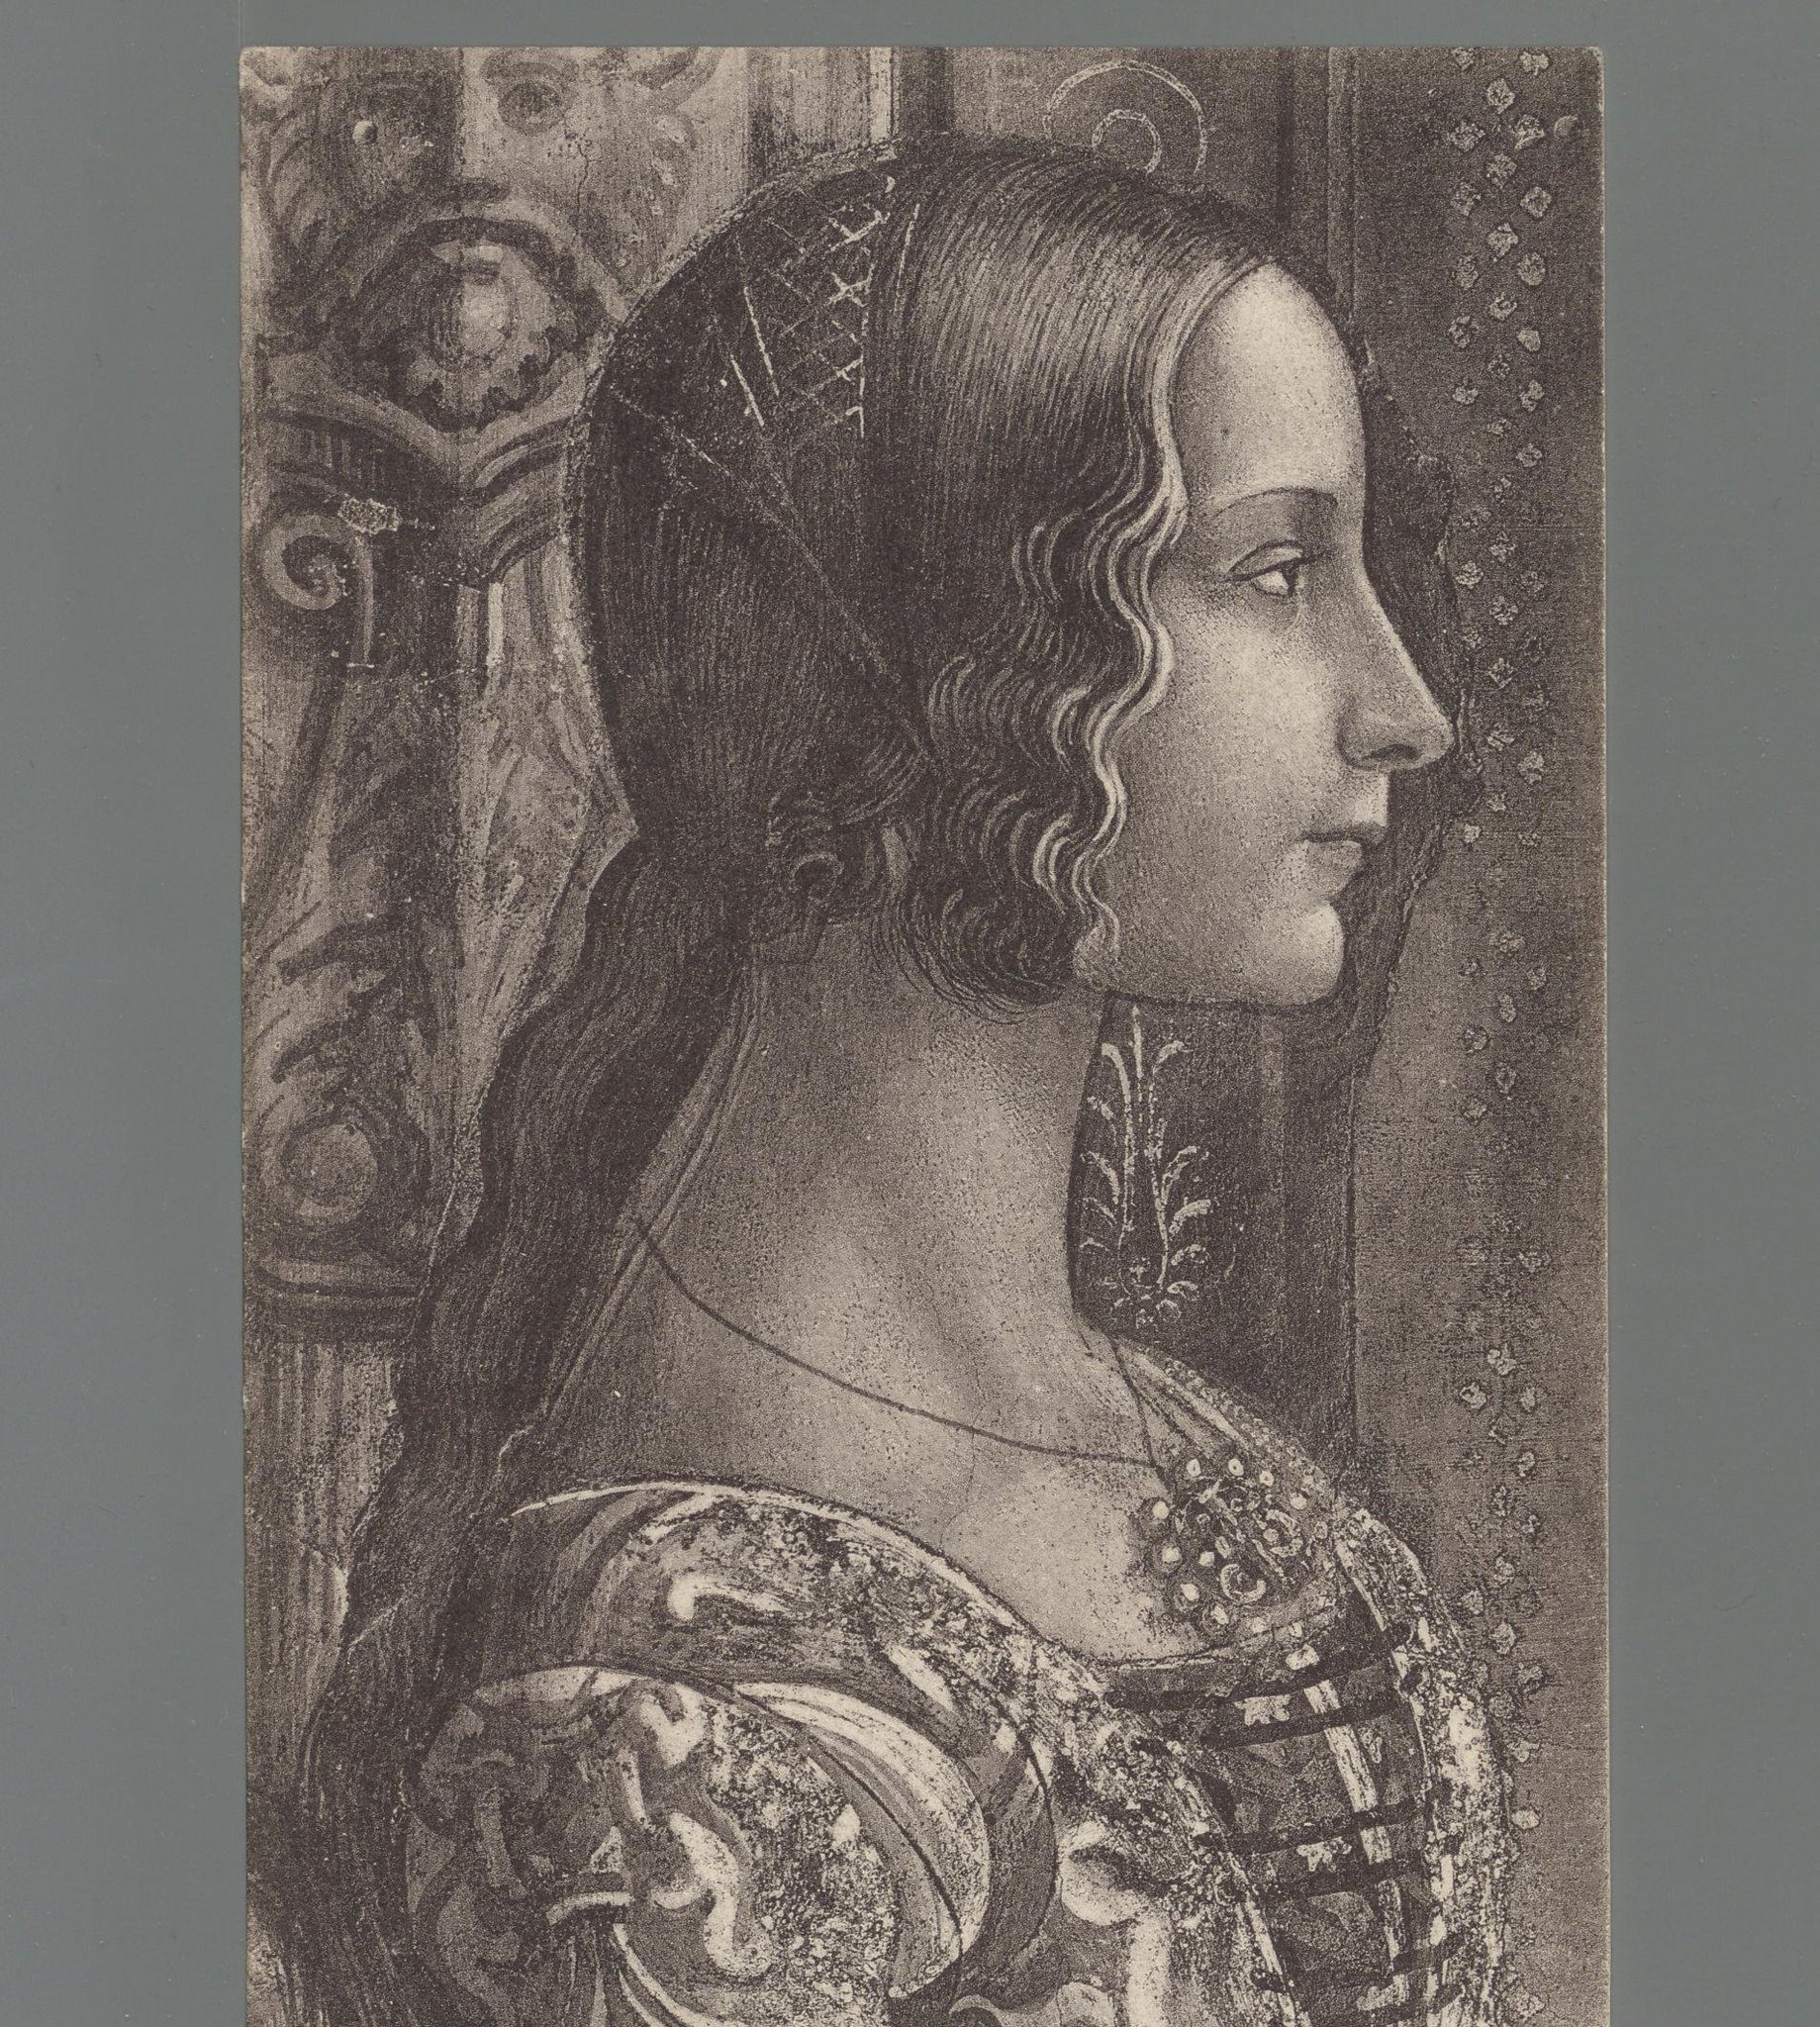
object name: photomechanical print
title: Firenze - Chiesa di S. Maria Novella. Un dettaglia dell'affresco. La Nascita della Vergine (Dom. Ghirlandaio)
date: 1906-1930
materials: cardboard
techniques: photograph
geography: florence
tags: church (exterior), picture, painting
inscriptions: collector's mark: ‘AFE v S’, inscription: ‘Edit. A. O. - Firenze’